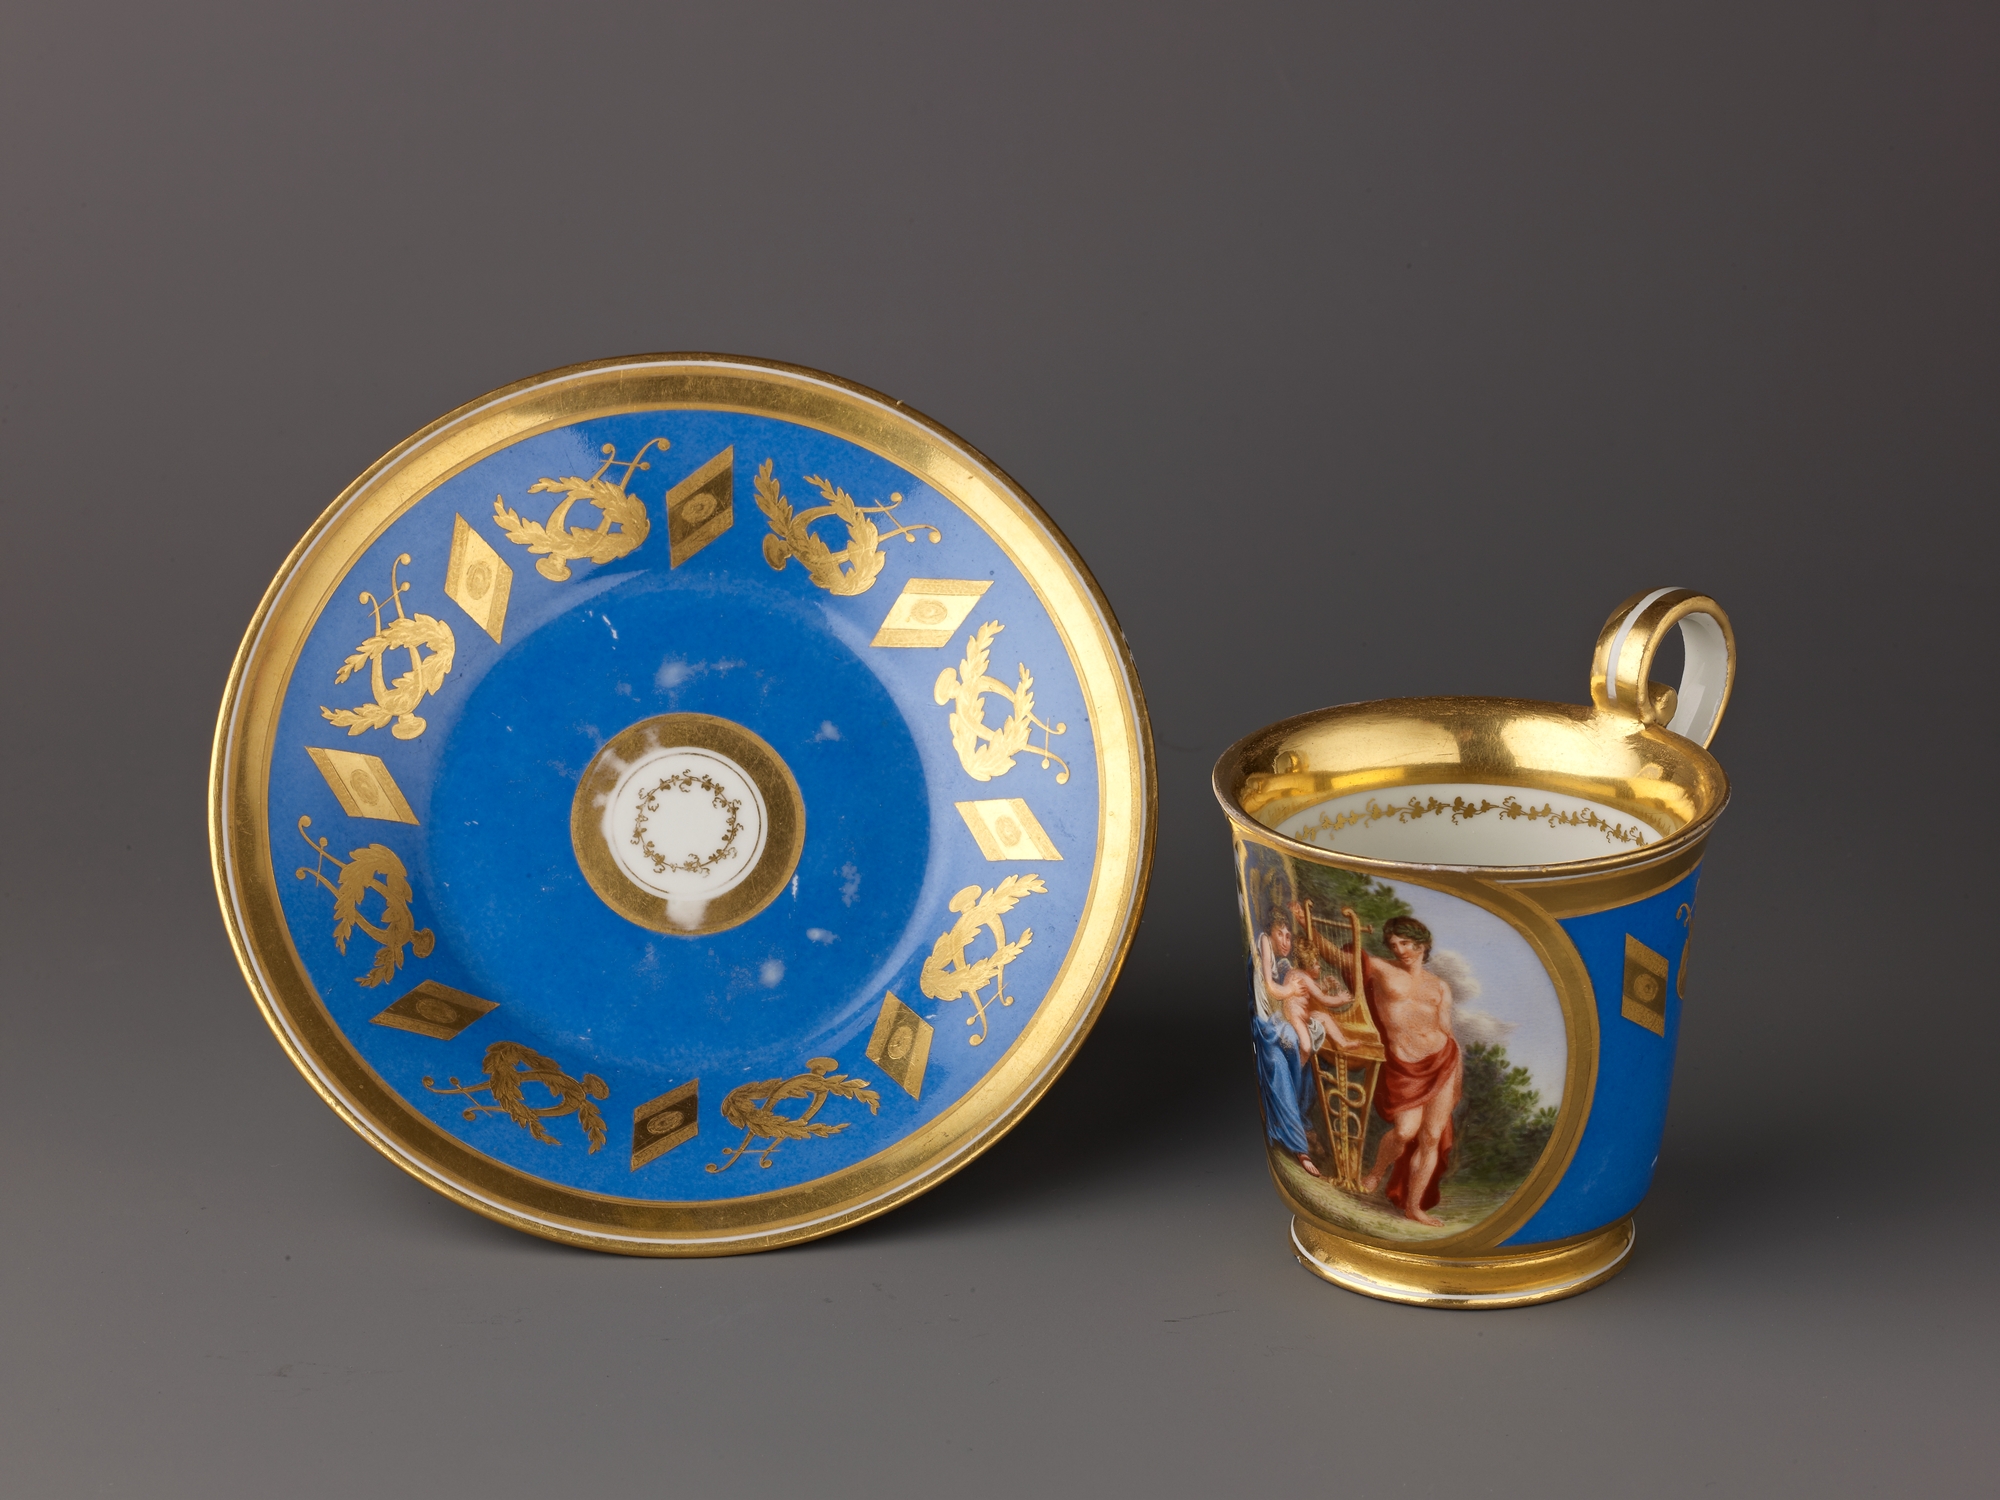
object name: cup and saucer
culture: austrian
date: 1815-1816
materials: hard paste porcelain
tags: children,men,women,lyres